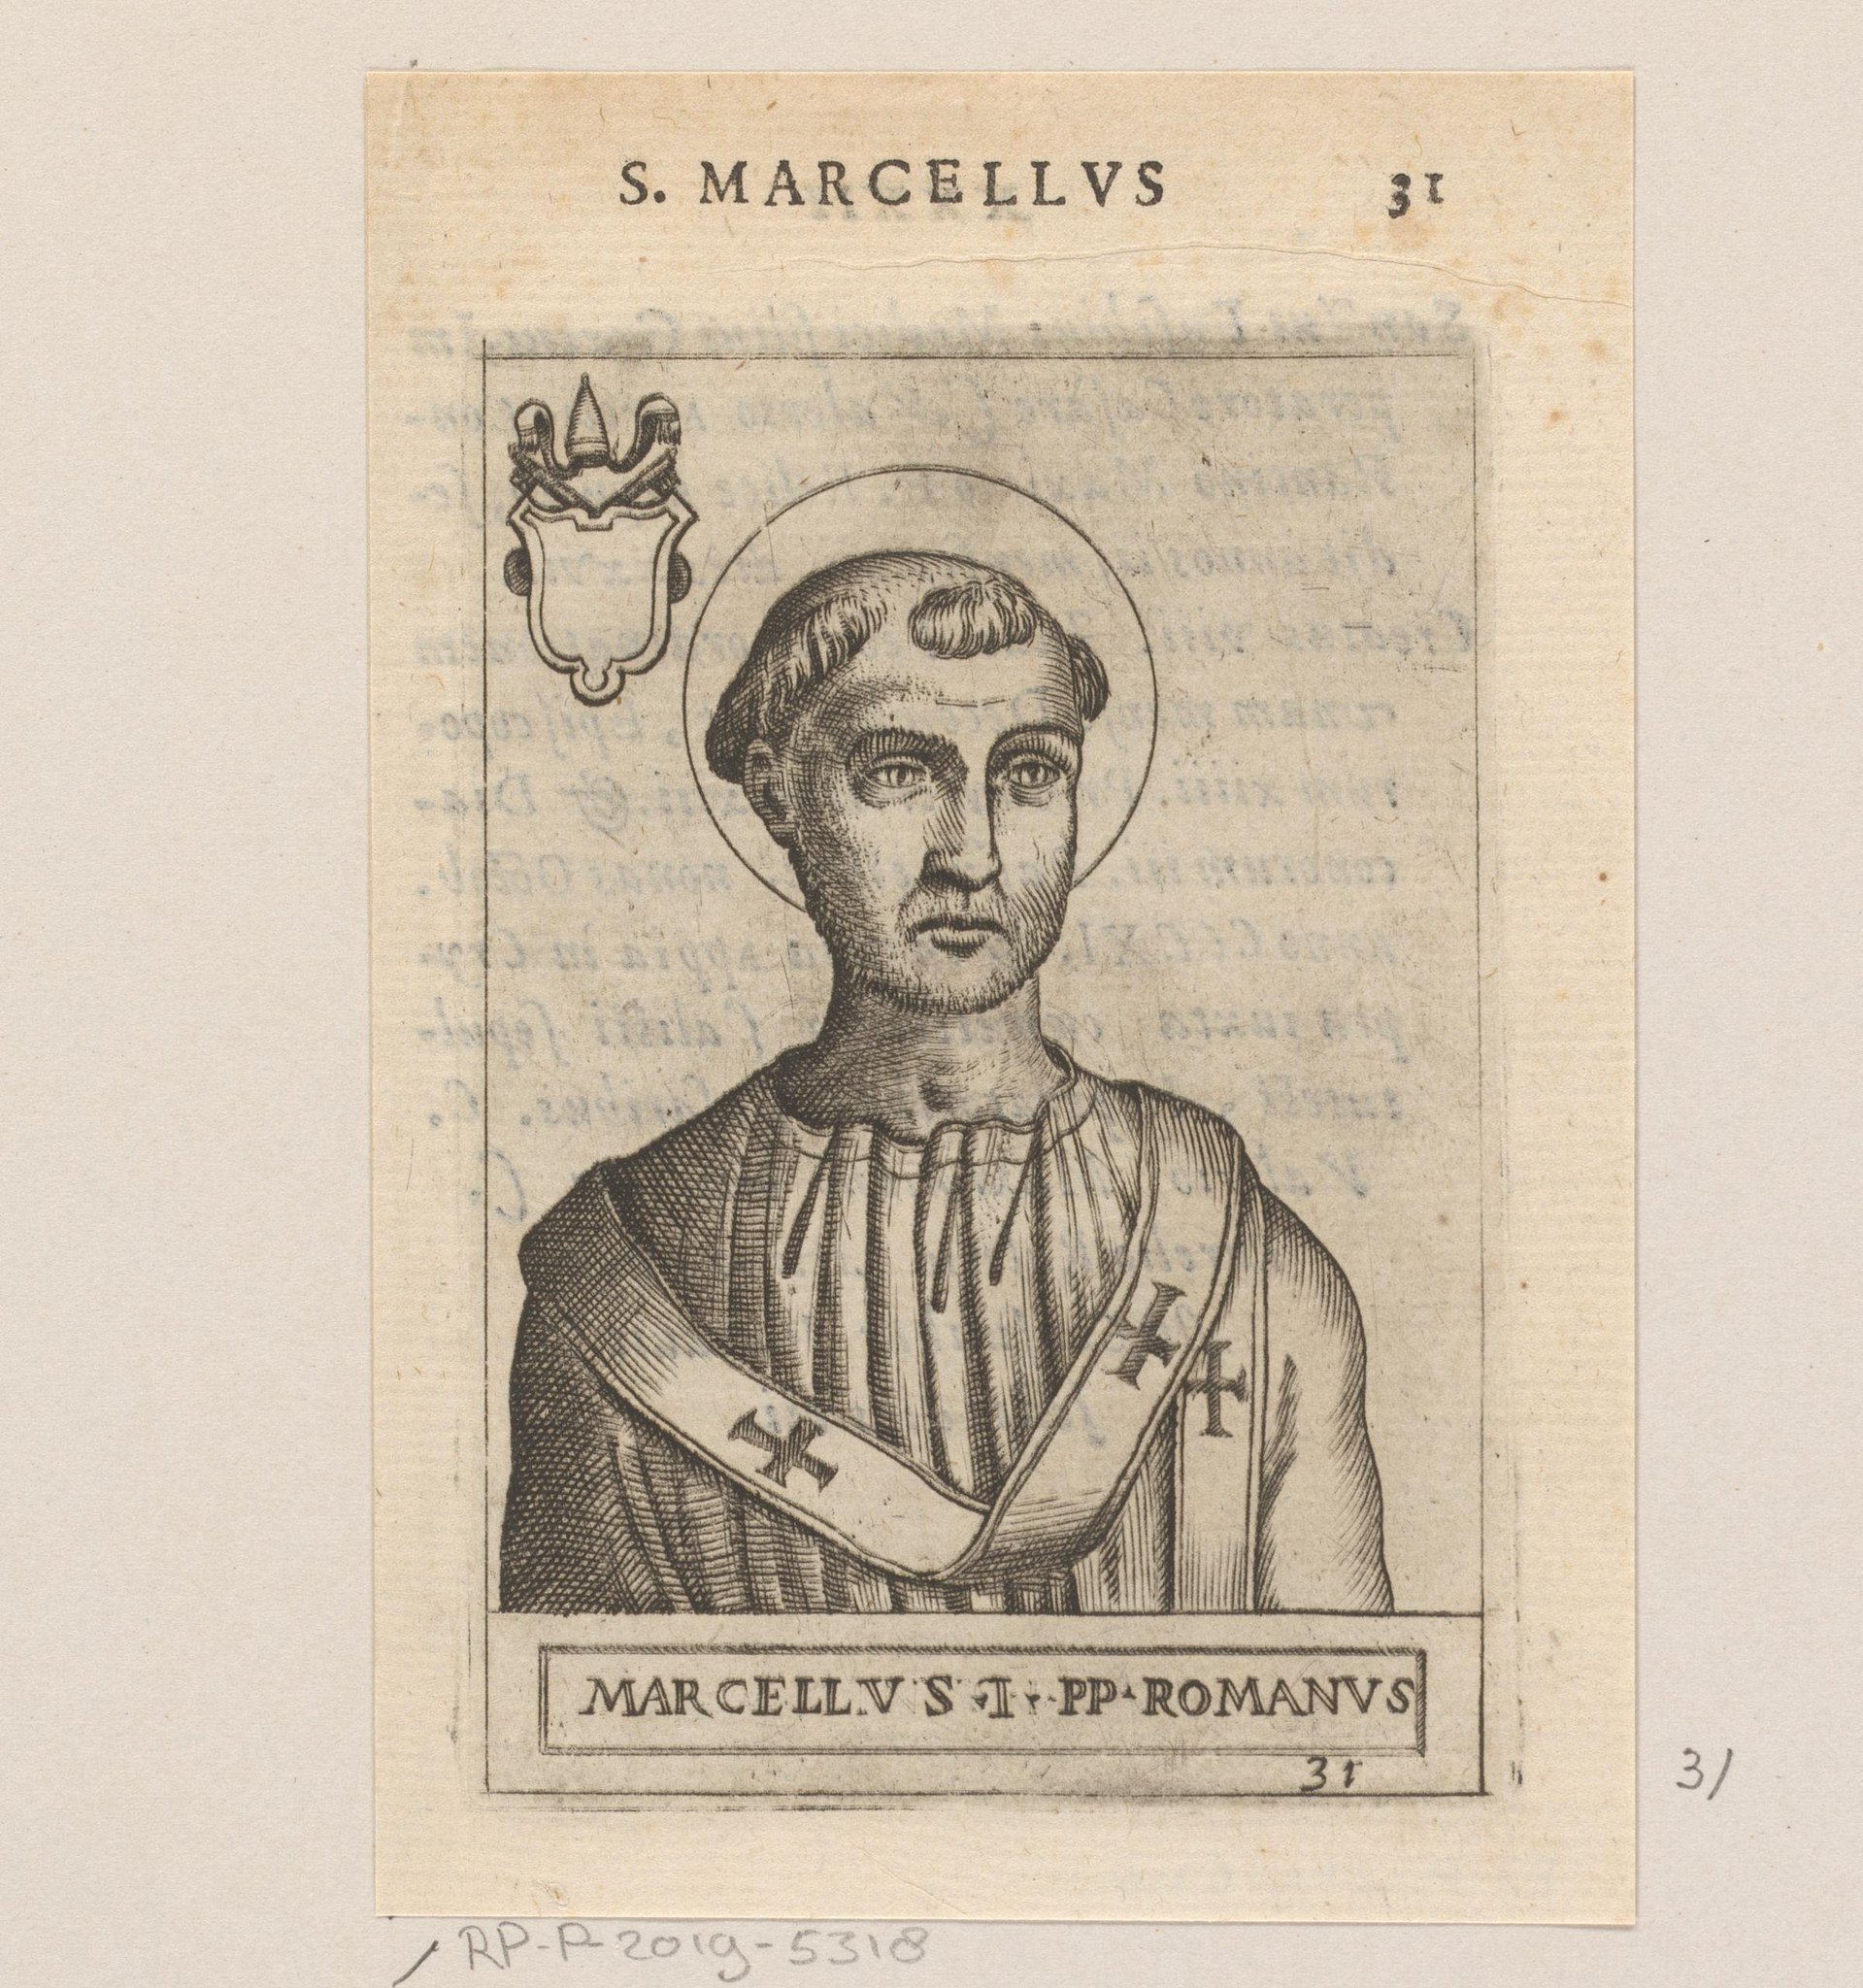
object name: print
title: Portret van paus Marcellus I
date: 1595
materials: paper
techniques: engraving, letterpress printing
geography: rome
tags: historical persons, pope, armorial bearing, heraldry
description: Prent uit: Cavalieri, Giovanni Battista de'. Effigies pontificum romanorum cum eorum vitis (...). Rome: Bartolomeo Bonfadino, 1595. Prent voor het eerst verschenen in: Cavalieri, Giovanni Battista de'. Pontificum romanorum effigies (...). Rome: Domenico Basa en Francesco Zanetti, 1580. Prent ook gebruikt in latere publicaties.